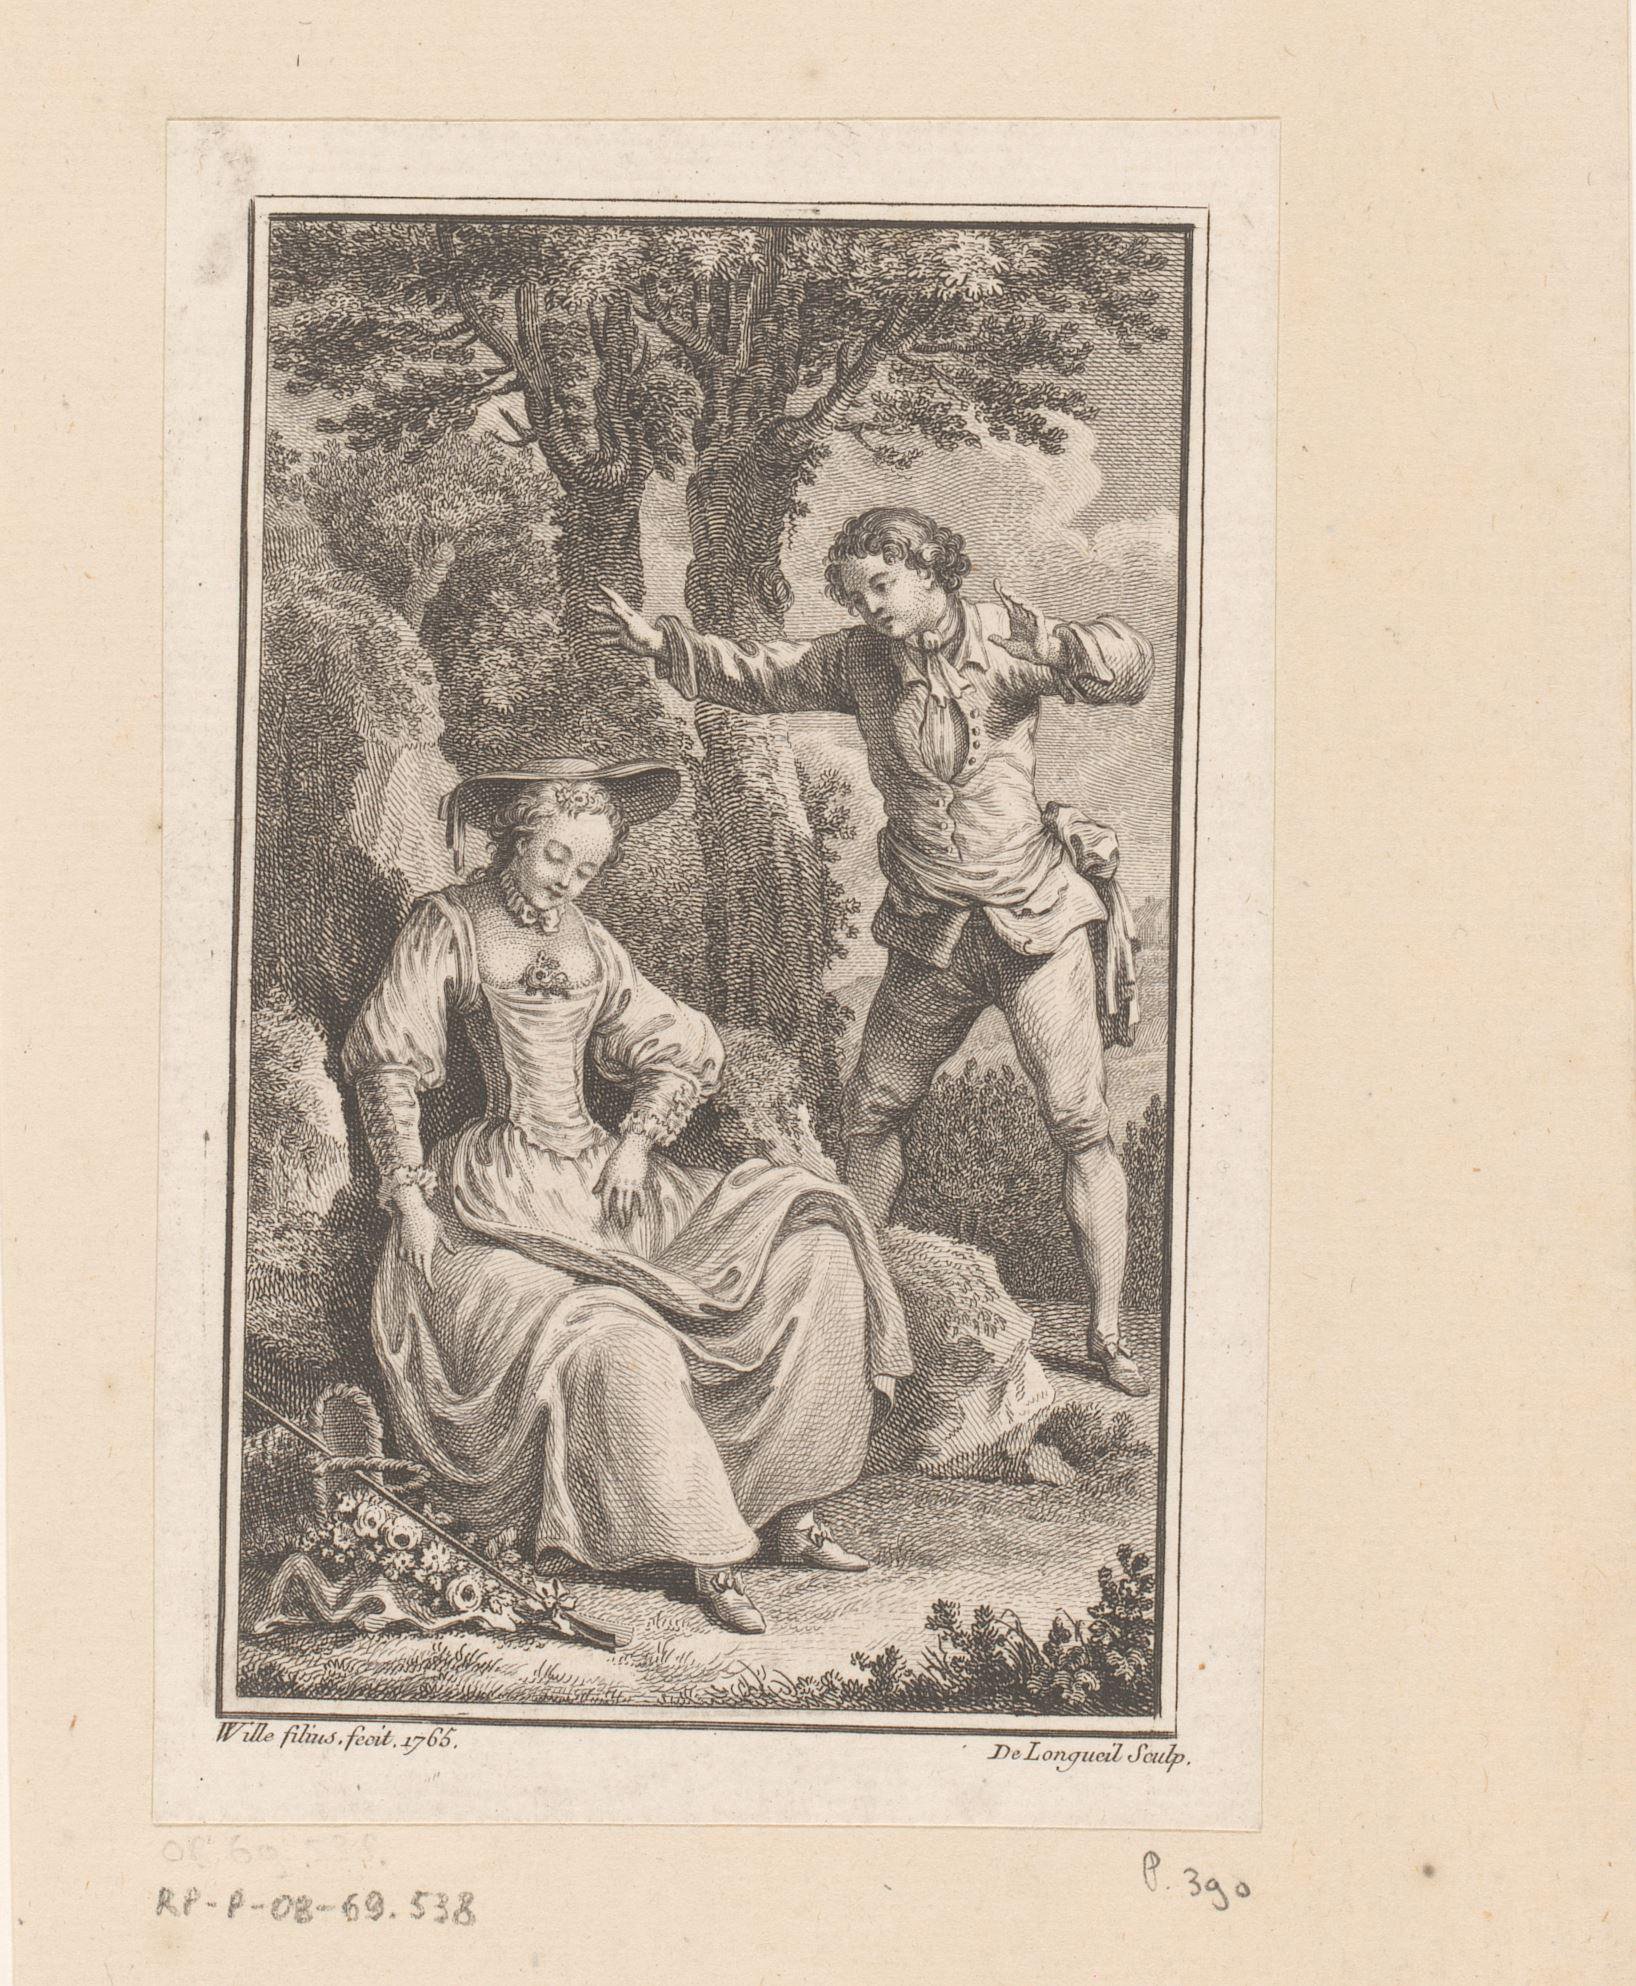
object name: print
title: Zintuigen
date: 1765-1792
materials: paper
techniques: engraving, etching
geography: france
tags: sitting figure - aa - female human figure, couple of lovers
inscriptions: collector's mark: Lugt 240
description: Mogelijk prent uit een boek of serie: 'Les sens'.